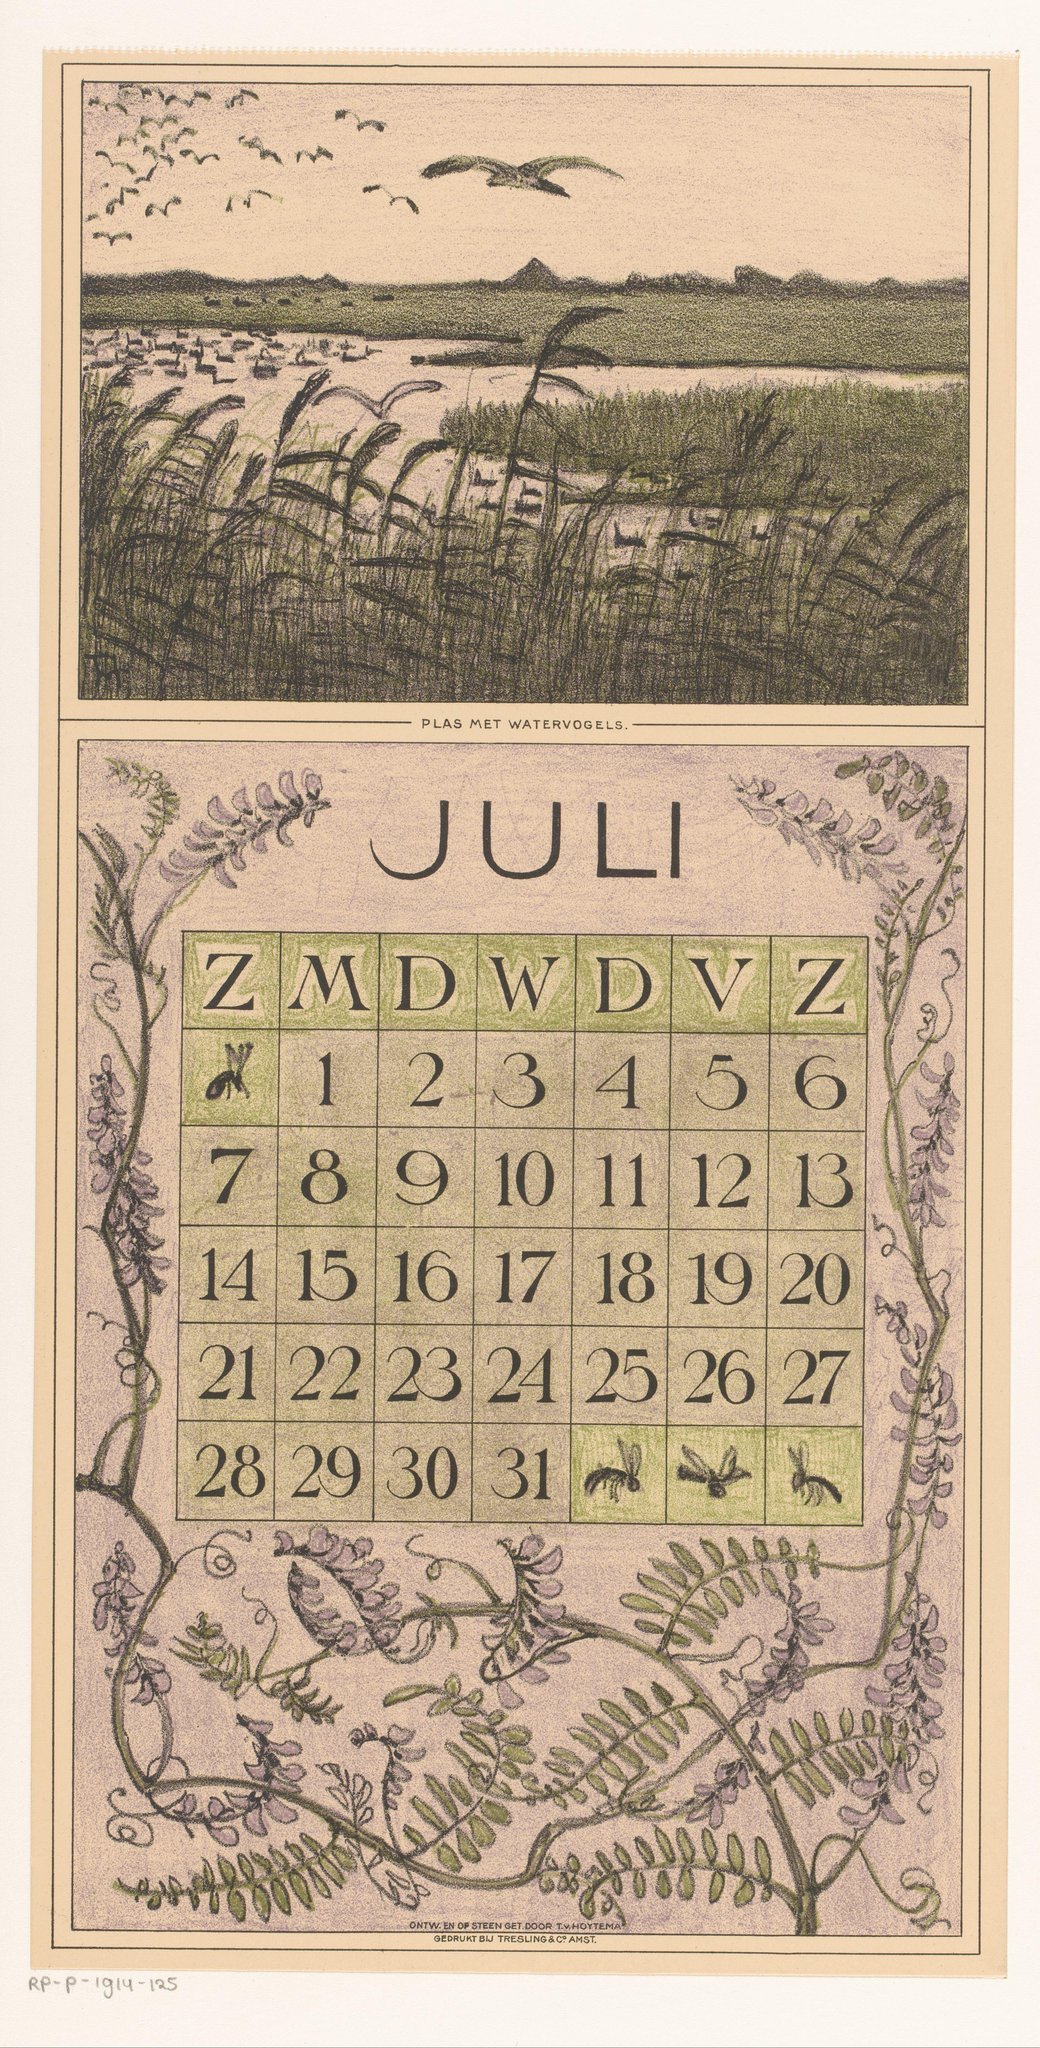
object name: calendar leaf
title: Plas met watervogels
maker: theo van hoytema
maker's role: draughtsman, painter, print maker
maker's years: 1863-1917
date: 1911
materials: paper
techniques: lithograph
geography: amsterdam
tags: birds, flowers: vetch, plants and herbs: reed, water-birds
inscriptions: collector's mark: Lugt 2228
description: Enkele vogels liggen op het water, anderen vliegen door de lucht. In de voorgrond riet. Rondom het calendarium vogelwikke. Bovenaan het blad een scheurlijn.